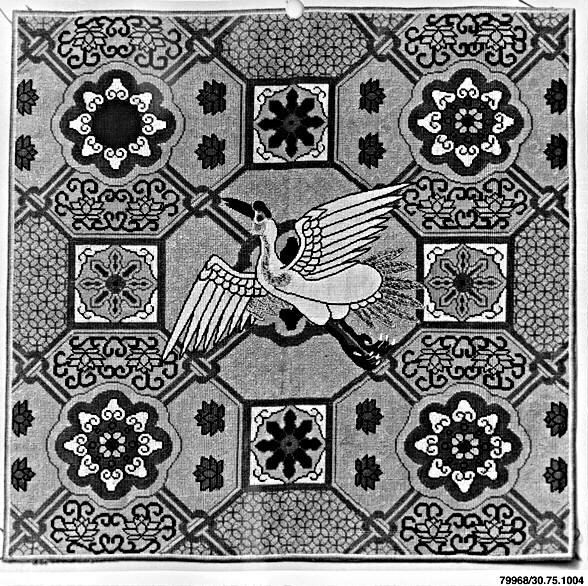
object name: rank badge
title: Rank Badge with Manchurian Crane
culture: chinese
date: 1801-1833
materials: canvas, silk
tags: cranes